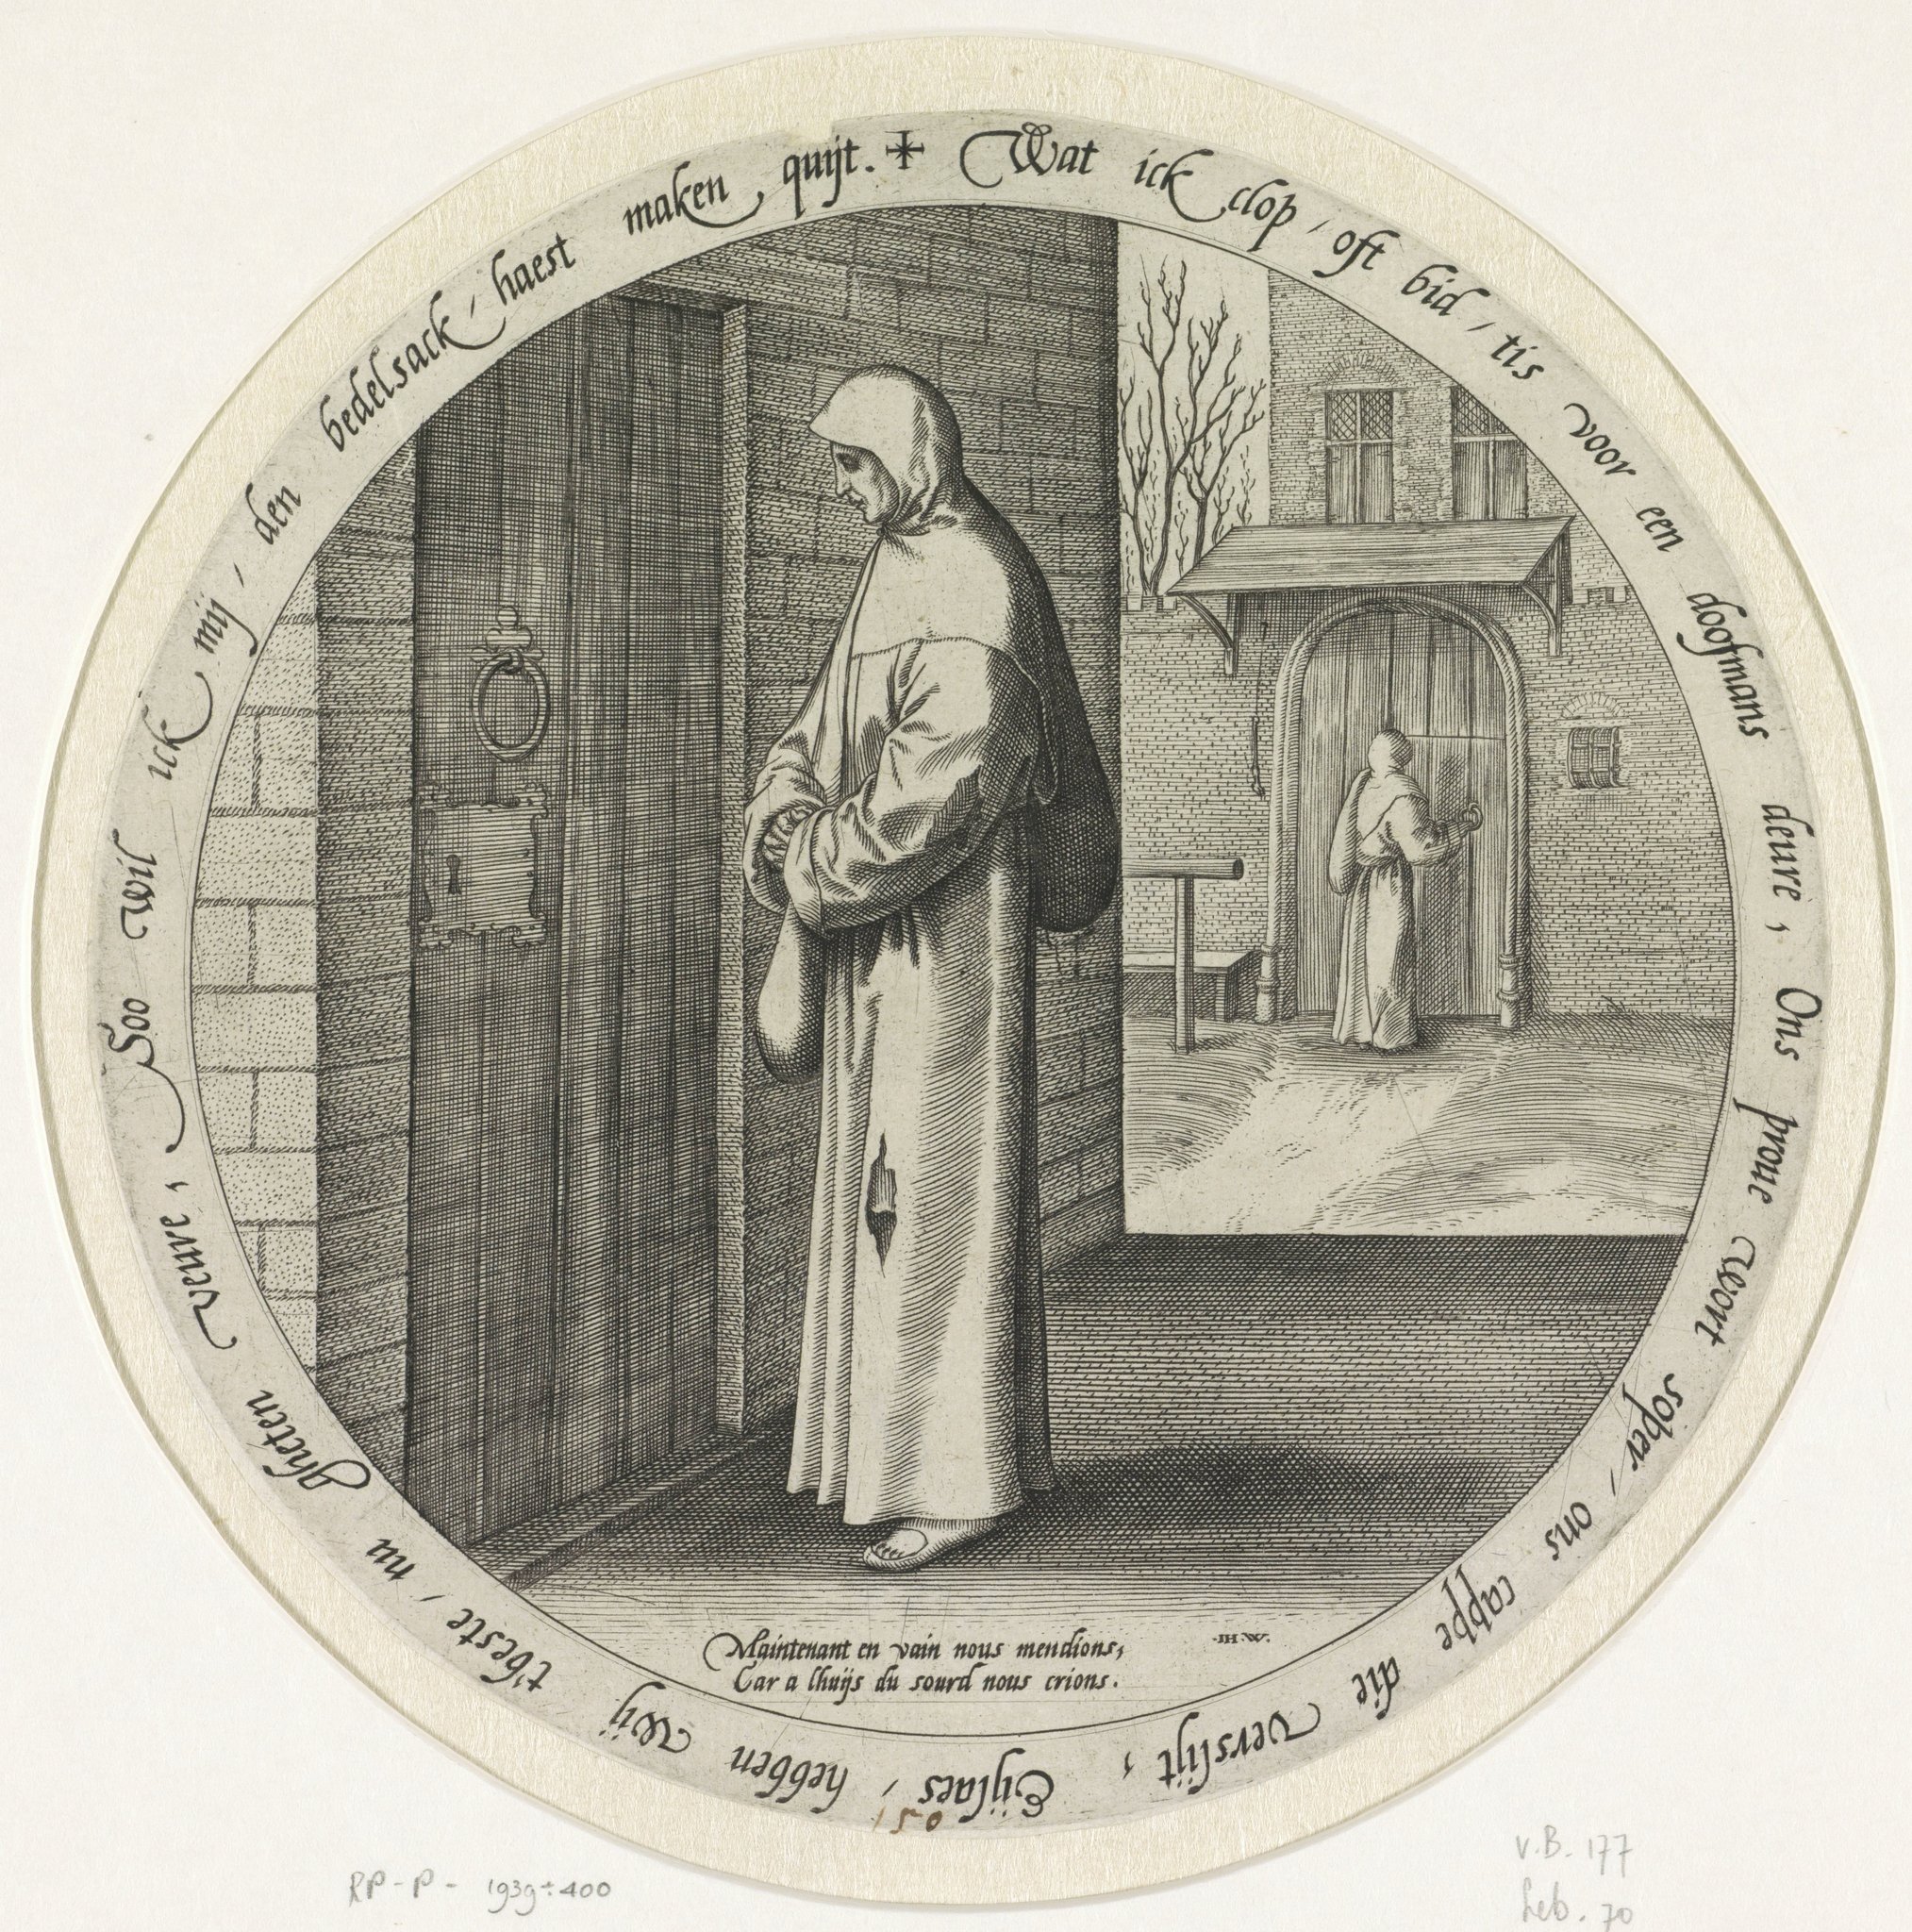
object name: print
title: Men bedelt voor niets aan de deur van de dove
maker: johannes wierix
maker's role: draughtsman, print maker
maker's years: 1549-1618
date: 1566-1570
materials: paper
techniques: engraving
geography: antwerp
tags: knocking at the door, deaf, deafness, proverbs, sayings, etc., beggar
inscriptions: collector's mark: Lugt 2228, : ‘Wat ick clop, oft bid, tis voor een doofmans deure (…)’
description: De bedelaars verbeelden het spreekwoord ‘Aan een dooven mans deur kloppen’, wat betekent dat iemand geen gehoor krijgt of een aanvraag niet ingewilligd wordt. De twee mannen staan voor gesloten deuren waar niet open wordt gedaan. Onderaan een toelichting in het Frans en in het randschrift staat het spreekwoord in het Nederlands.